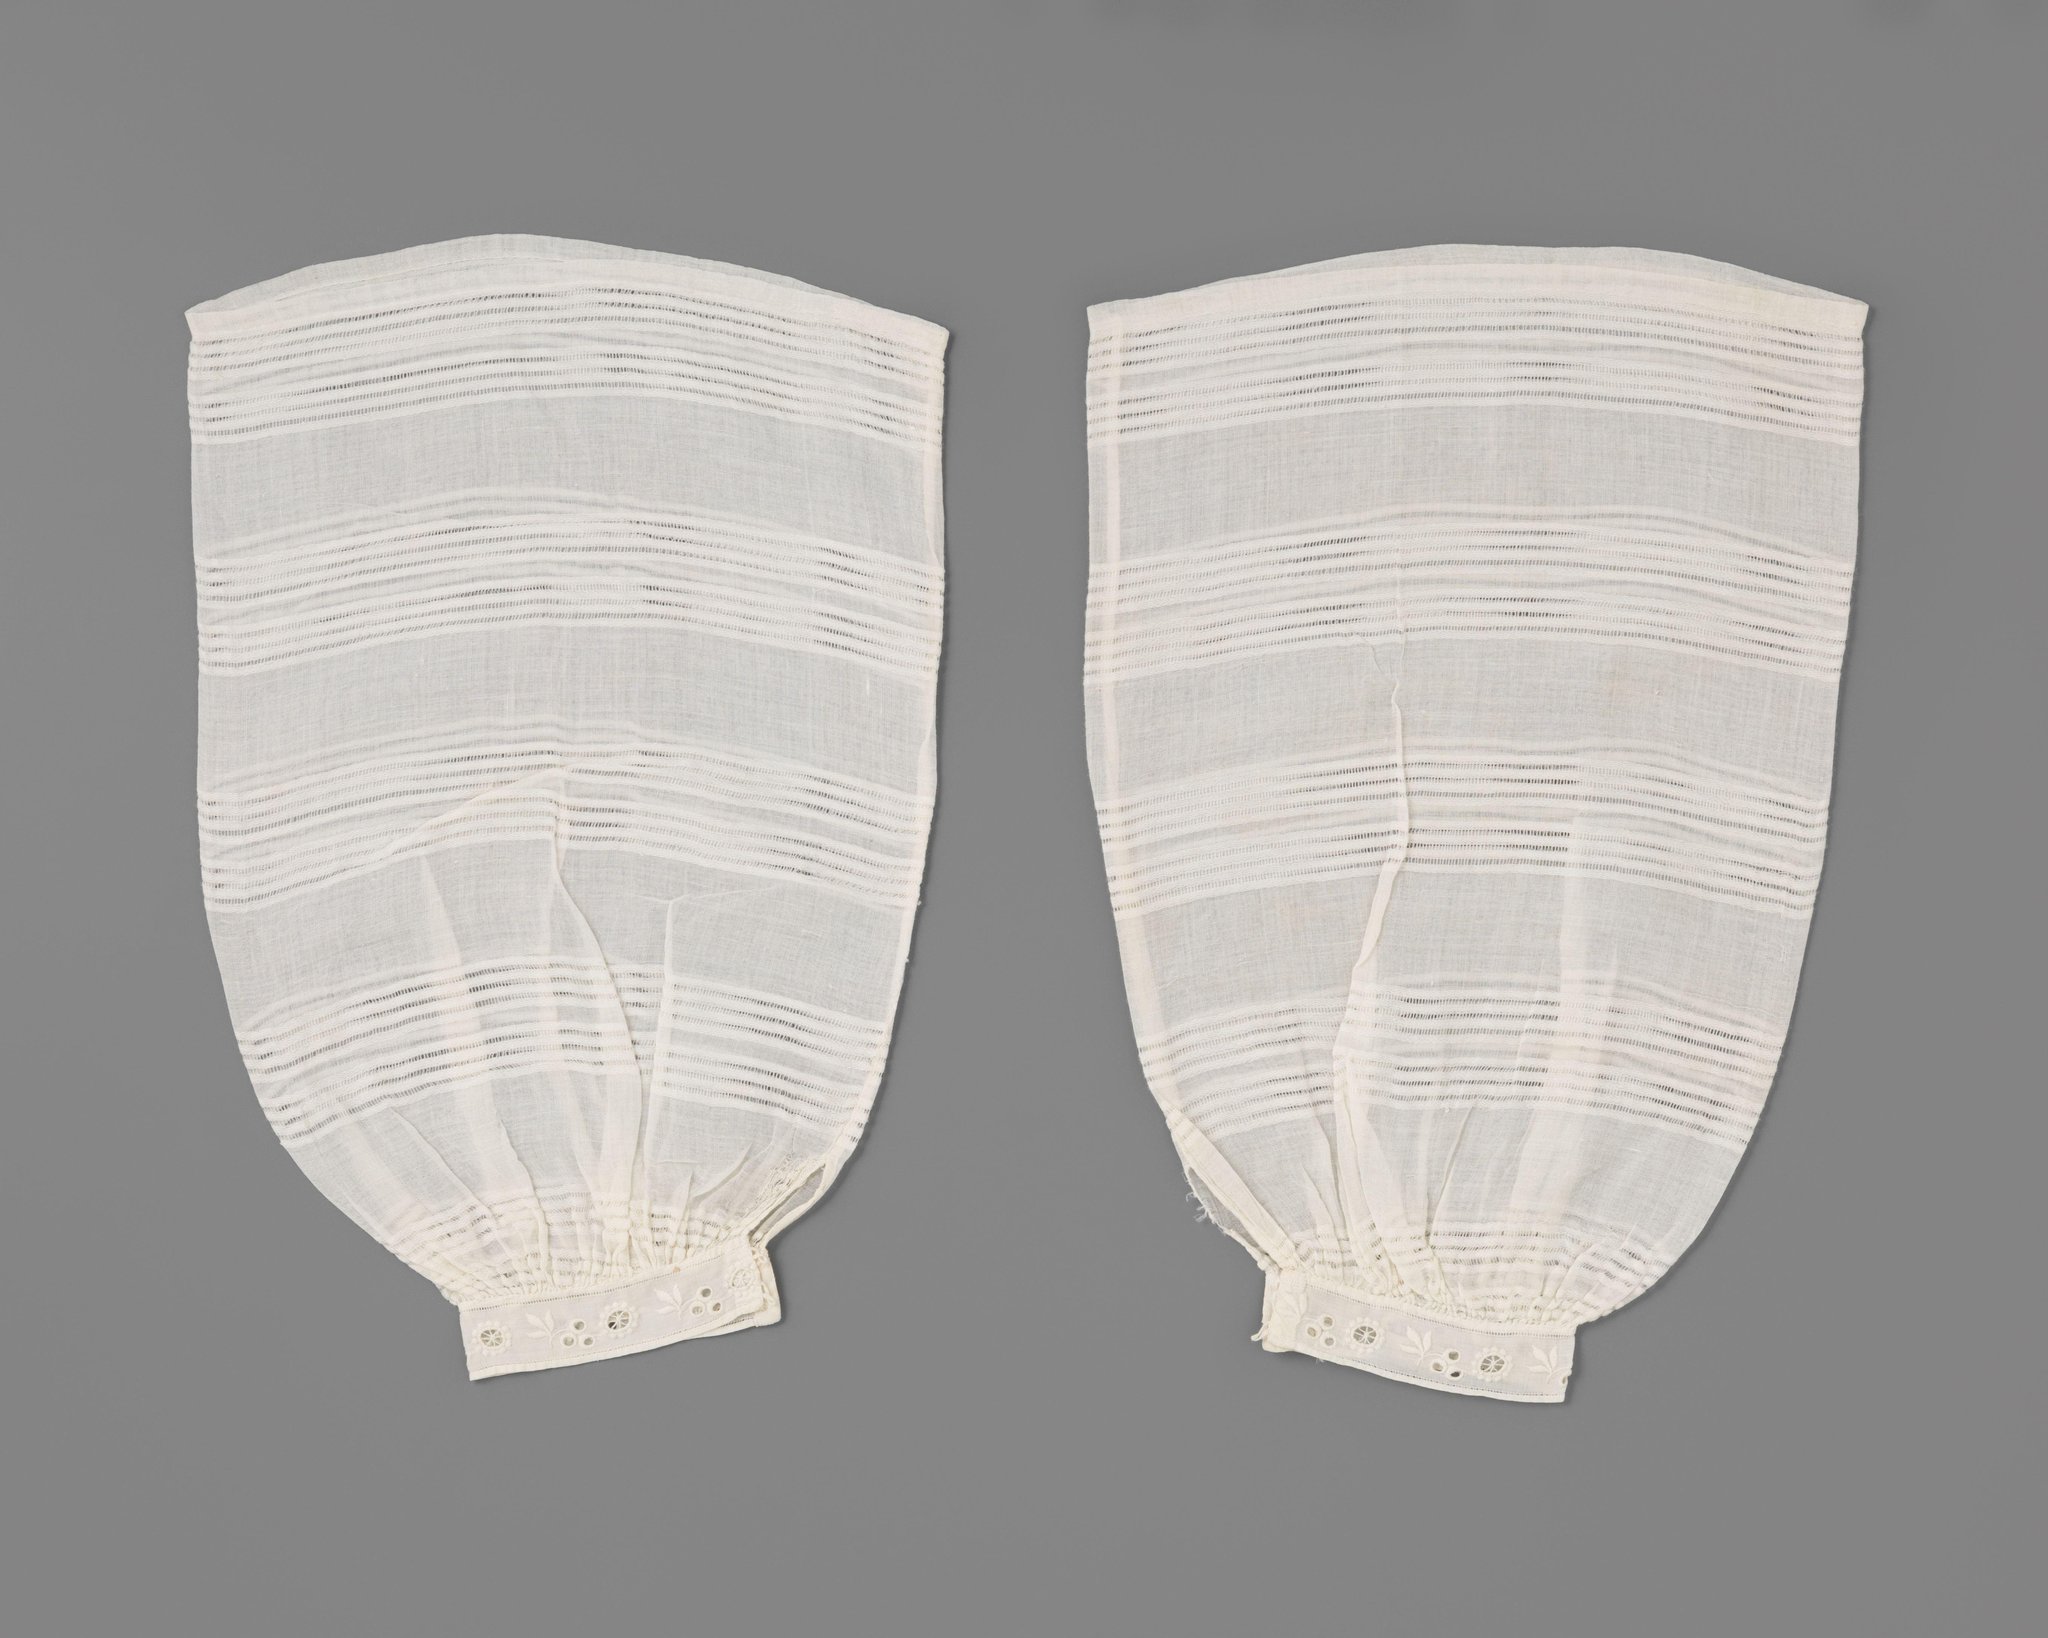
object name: womenswear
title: Ondermouw, ballonvormig, versierd met ajour dwarsstrepen en geborduurde wieltjes en bessen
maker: Anonymous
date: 1850-1875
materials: textile, glass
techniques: embroidery, embroidered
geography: netherlands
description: Ondermouw van batist, ballonvormig. De mouw is gerimpeld aan de manchet bevestigd, en heeft een versiering in de vorm van ajour dwarsstrepen. De manchet is versierd met wit borduurwerk in de vorm van bessen en wieltjes. Aan de manchet twee knopen.